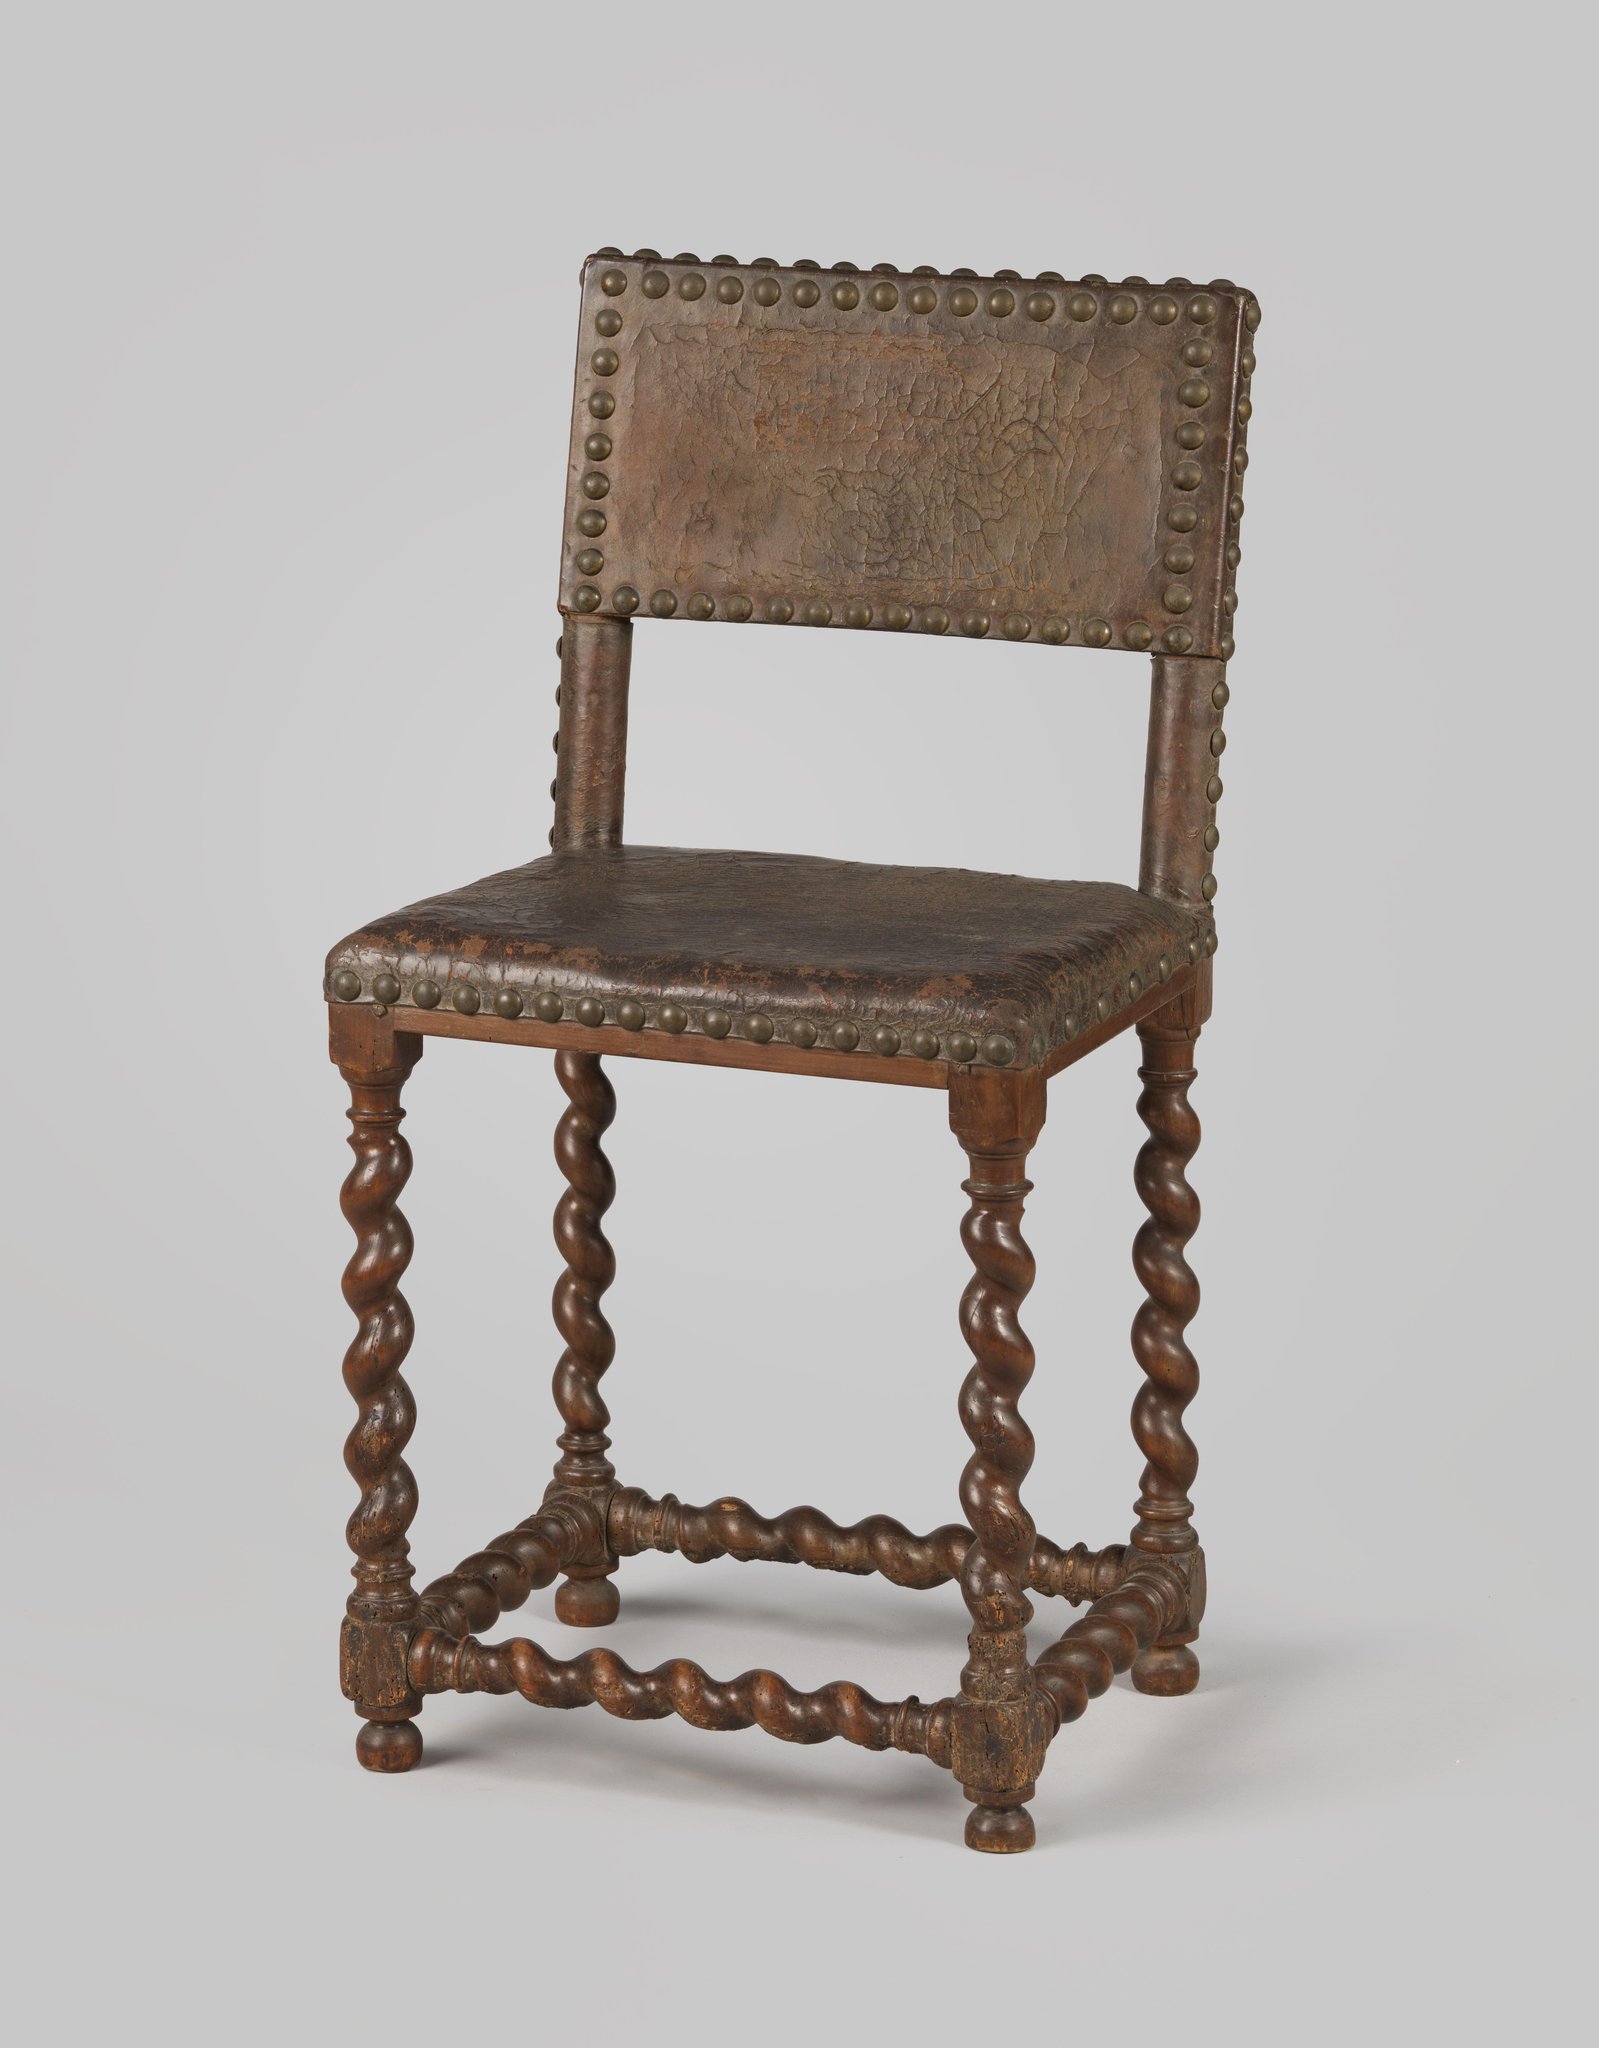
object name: chair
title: Stoel met geslingerde poten en sporten; rug en zitting bekleed met leer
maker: Anonymous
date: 1640-1660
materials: leather, wood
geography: netherlands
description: Stoel van pruimenhout,bekleed met leer. Het meubel heeft geslingerde poten, die door vier eveneens geslingerde ondersporten verbonden zijn. De rug is gedubbeld; de achterstijlen tussen zitting en rug zijn met leer omkleed. De zitting heeft nog de oude vulling en singels.